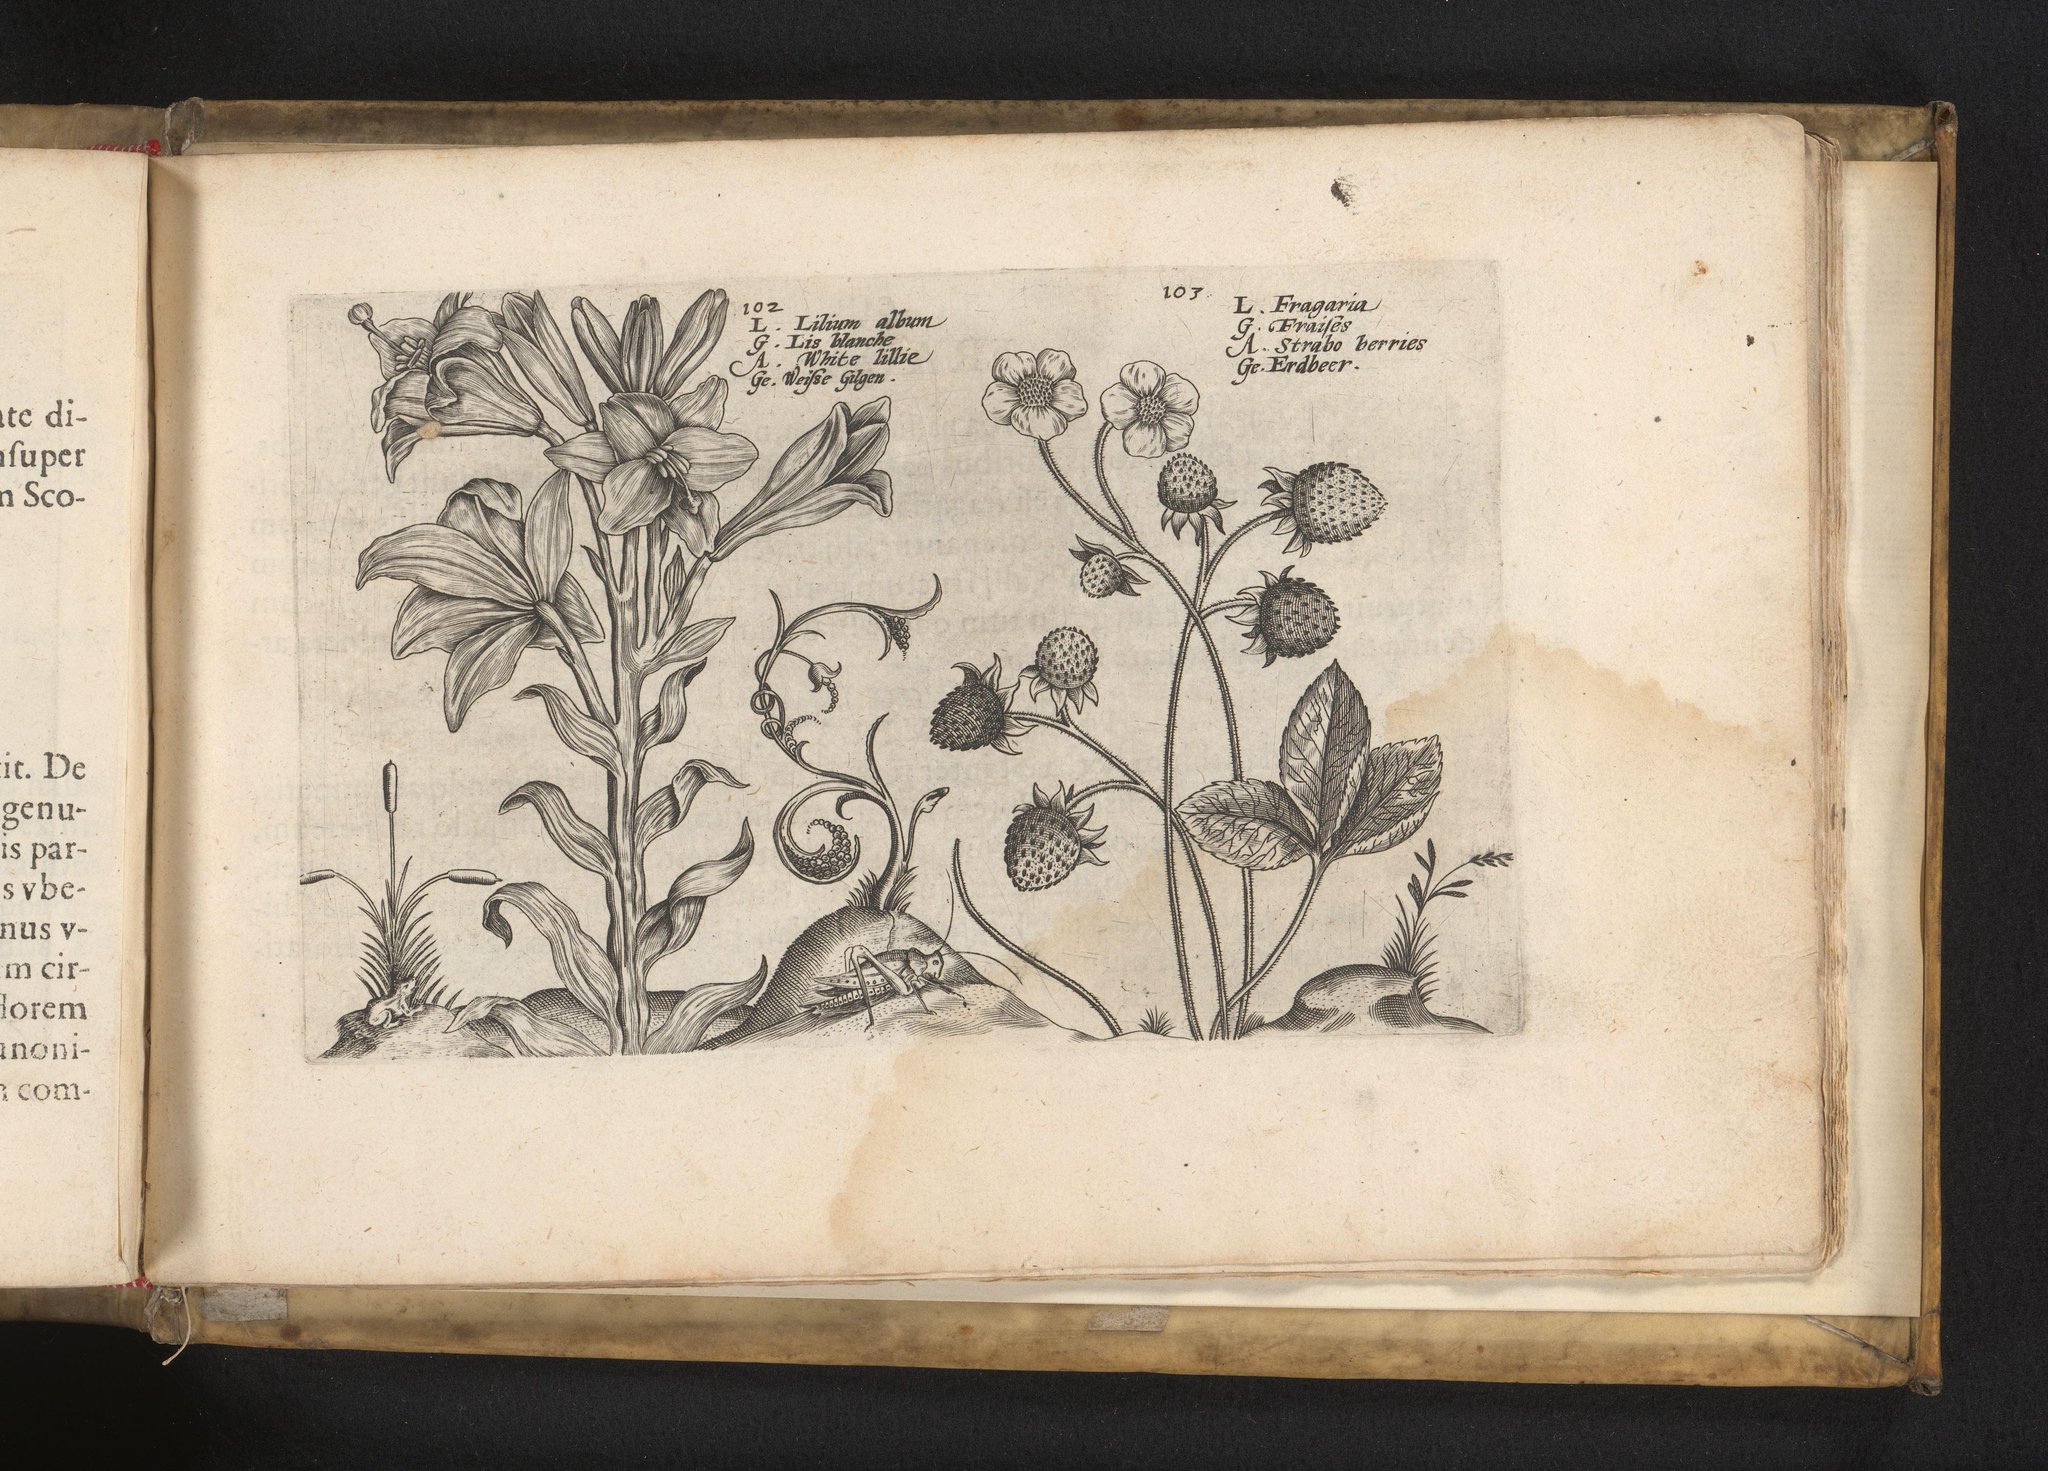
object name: book illustration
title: Madonnalelie en aardbei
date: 1617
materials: paper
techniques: engraving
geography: arnhem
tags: flowers, fruits: strawberry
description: Prent uit: Passe, Crispijn van de (II). Hortus floridus in quo rariorum & minus vulgarium florum icones ad vivam veramque formam. Arnhem: Johannes Janssonius, 1617.